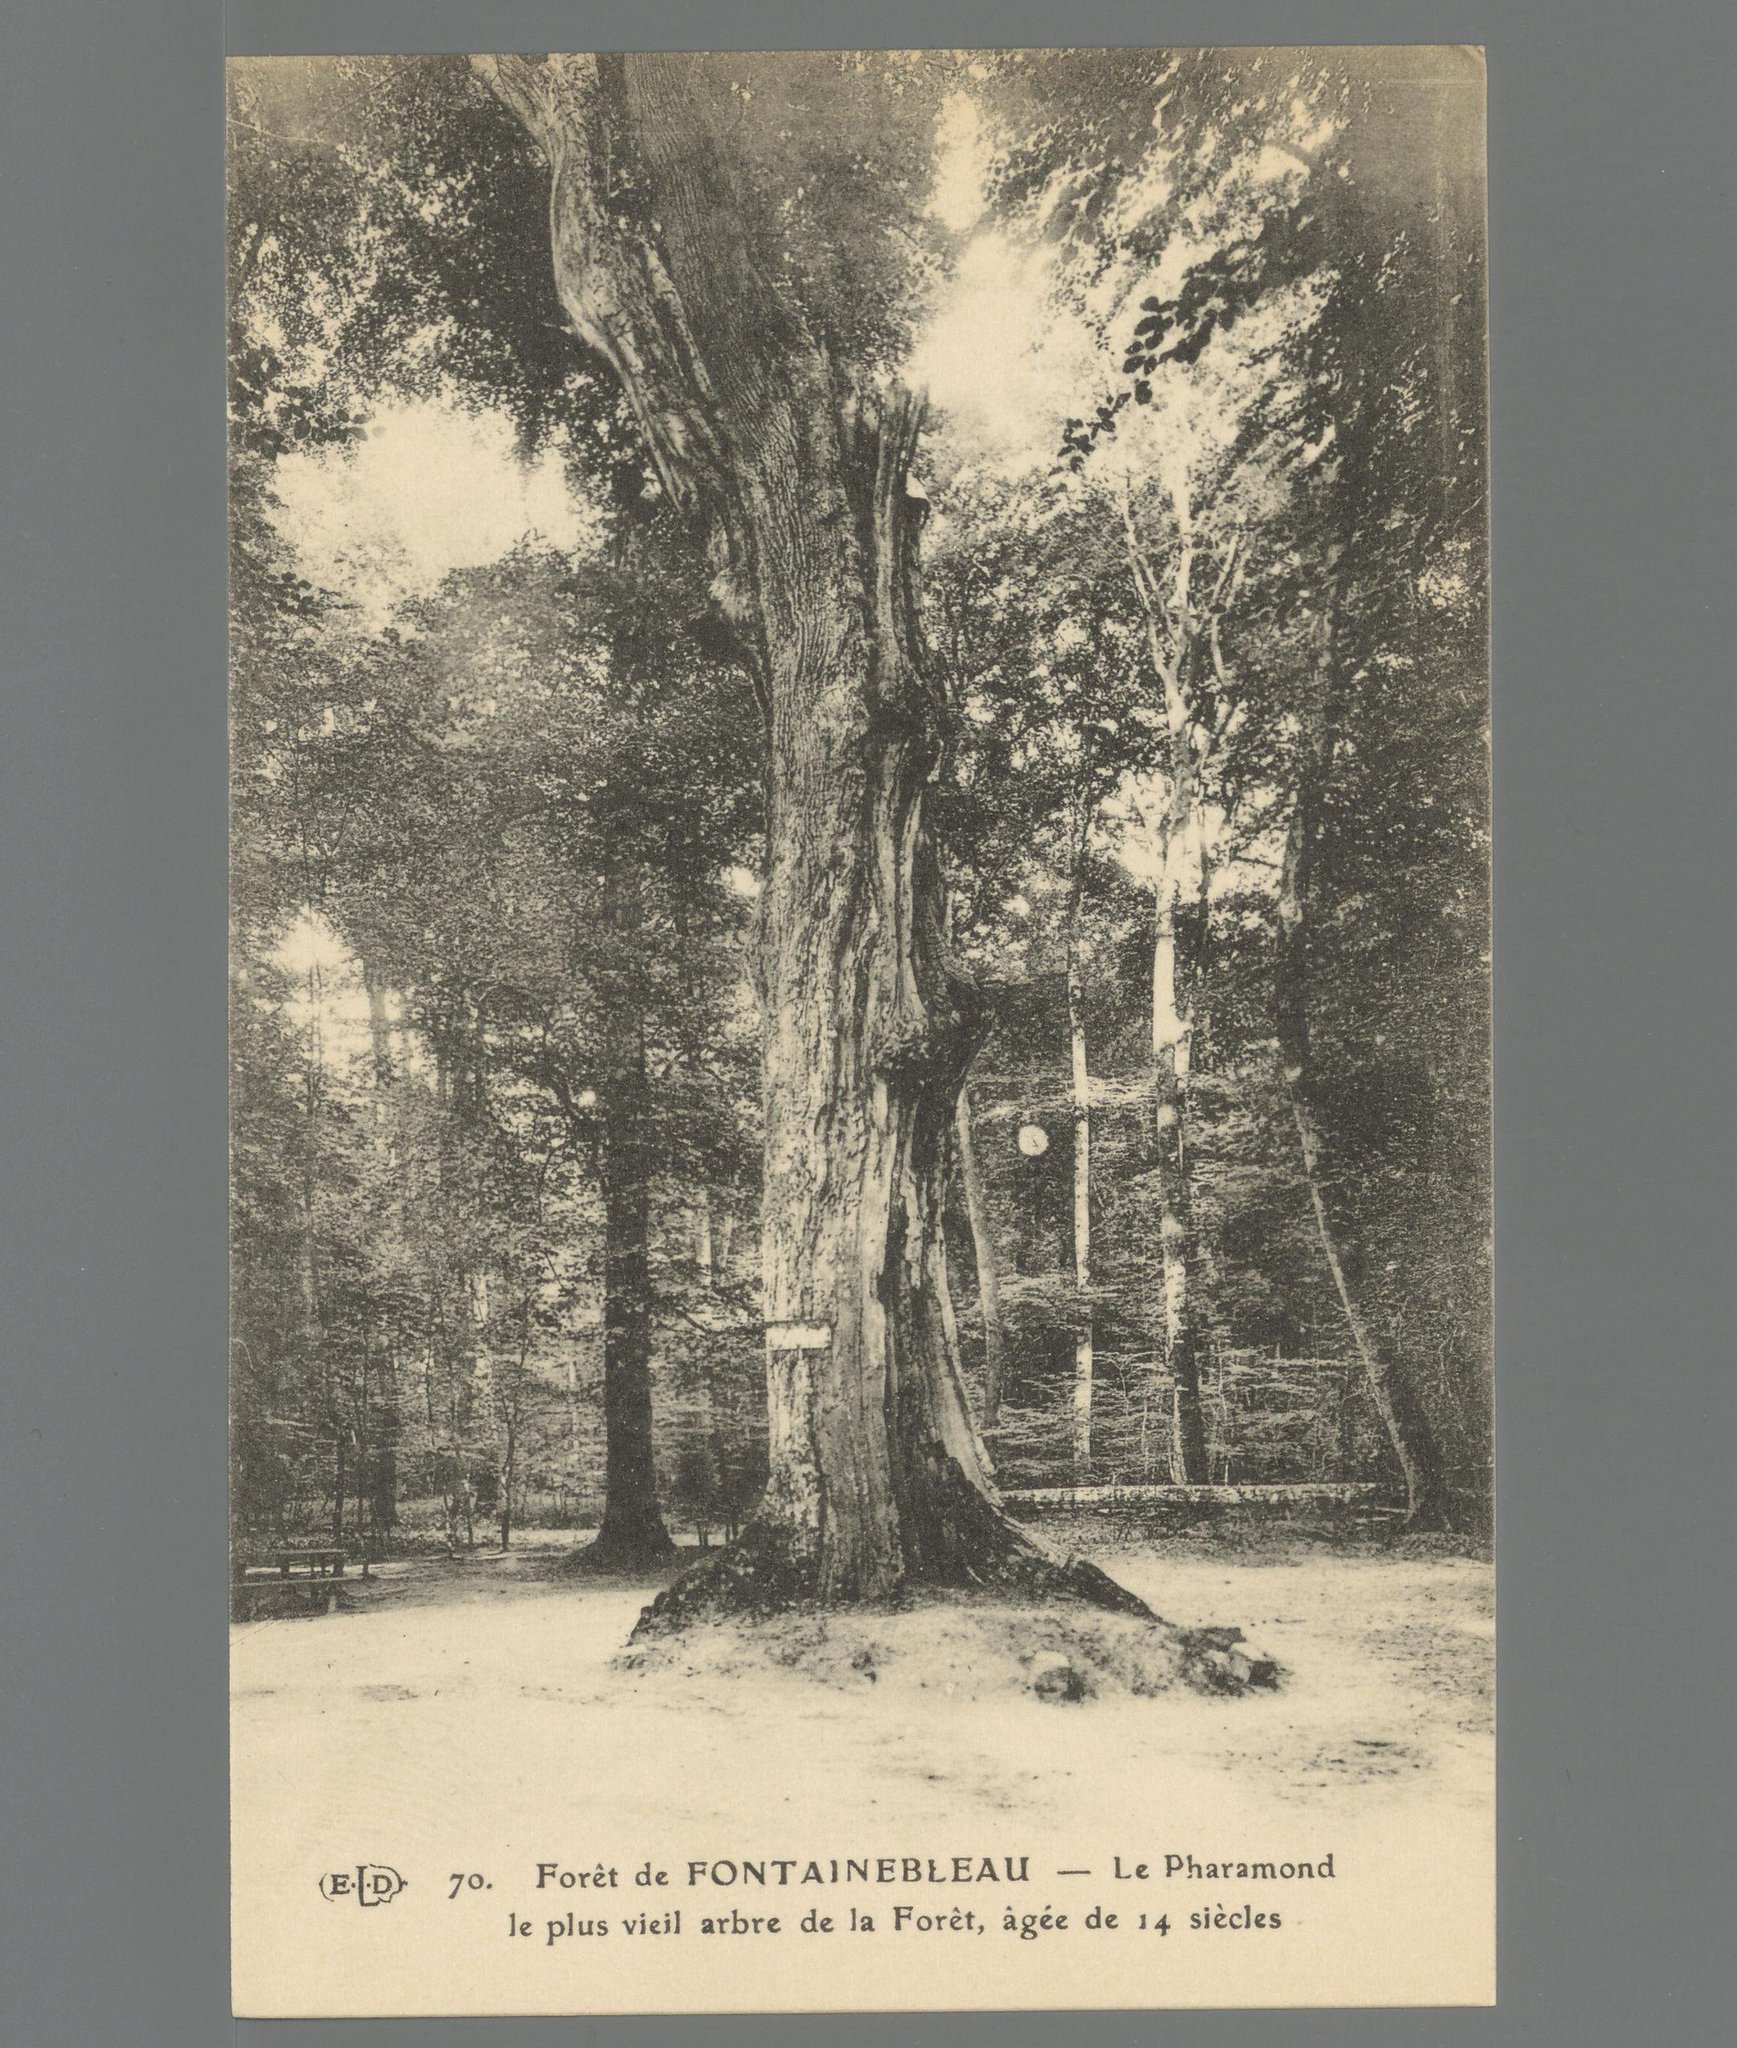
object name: photomechanical print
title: Fôret de Fontainebleau. Le Pharamond. Le plus vieil arbre de la Fôret, âgée de 14 siècles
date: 1904-1906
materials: cardboard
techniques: photograph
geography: fontainebleau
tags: trees, forest, wood